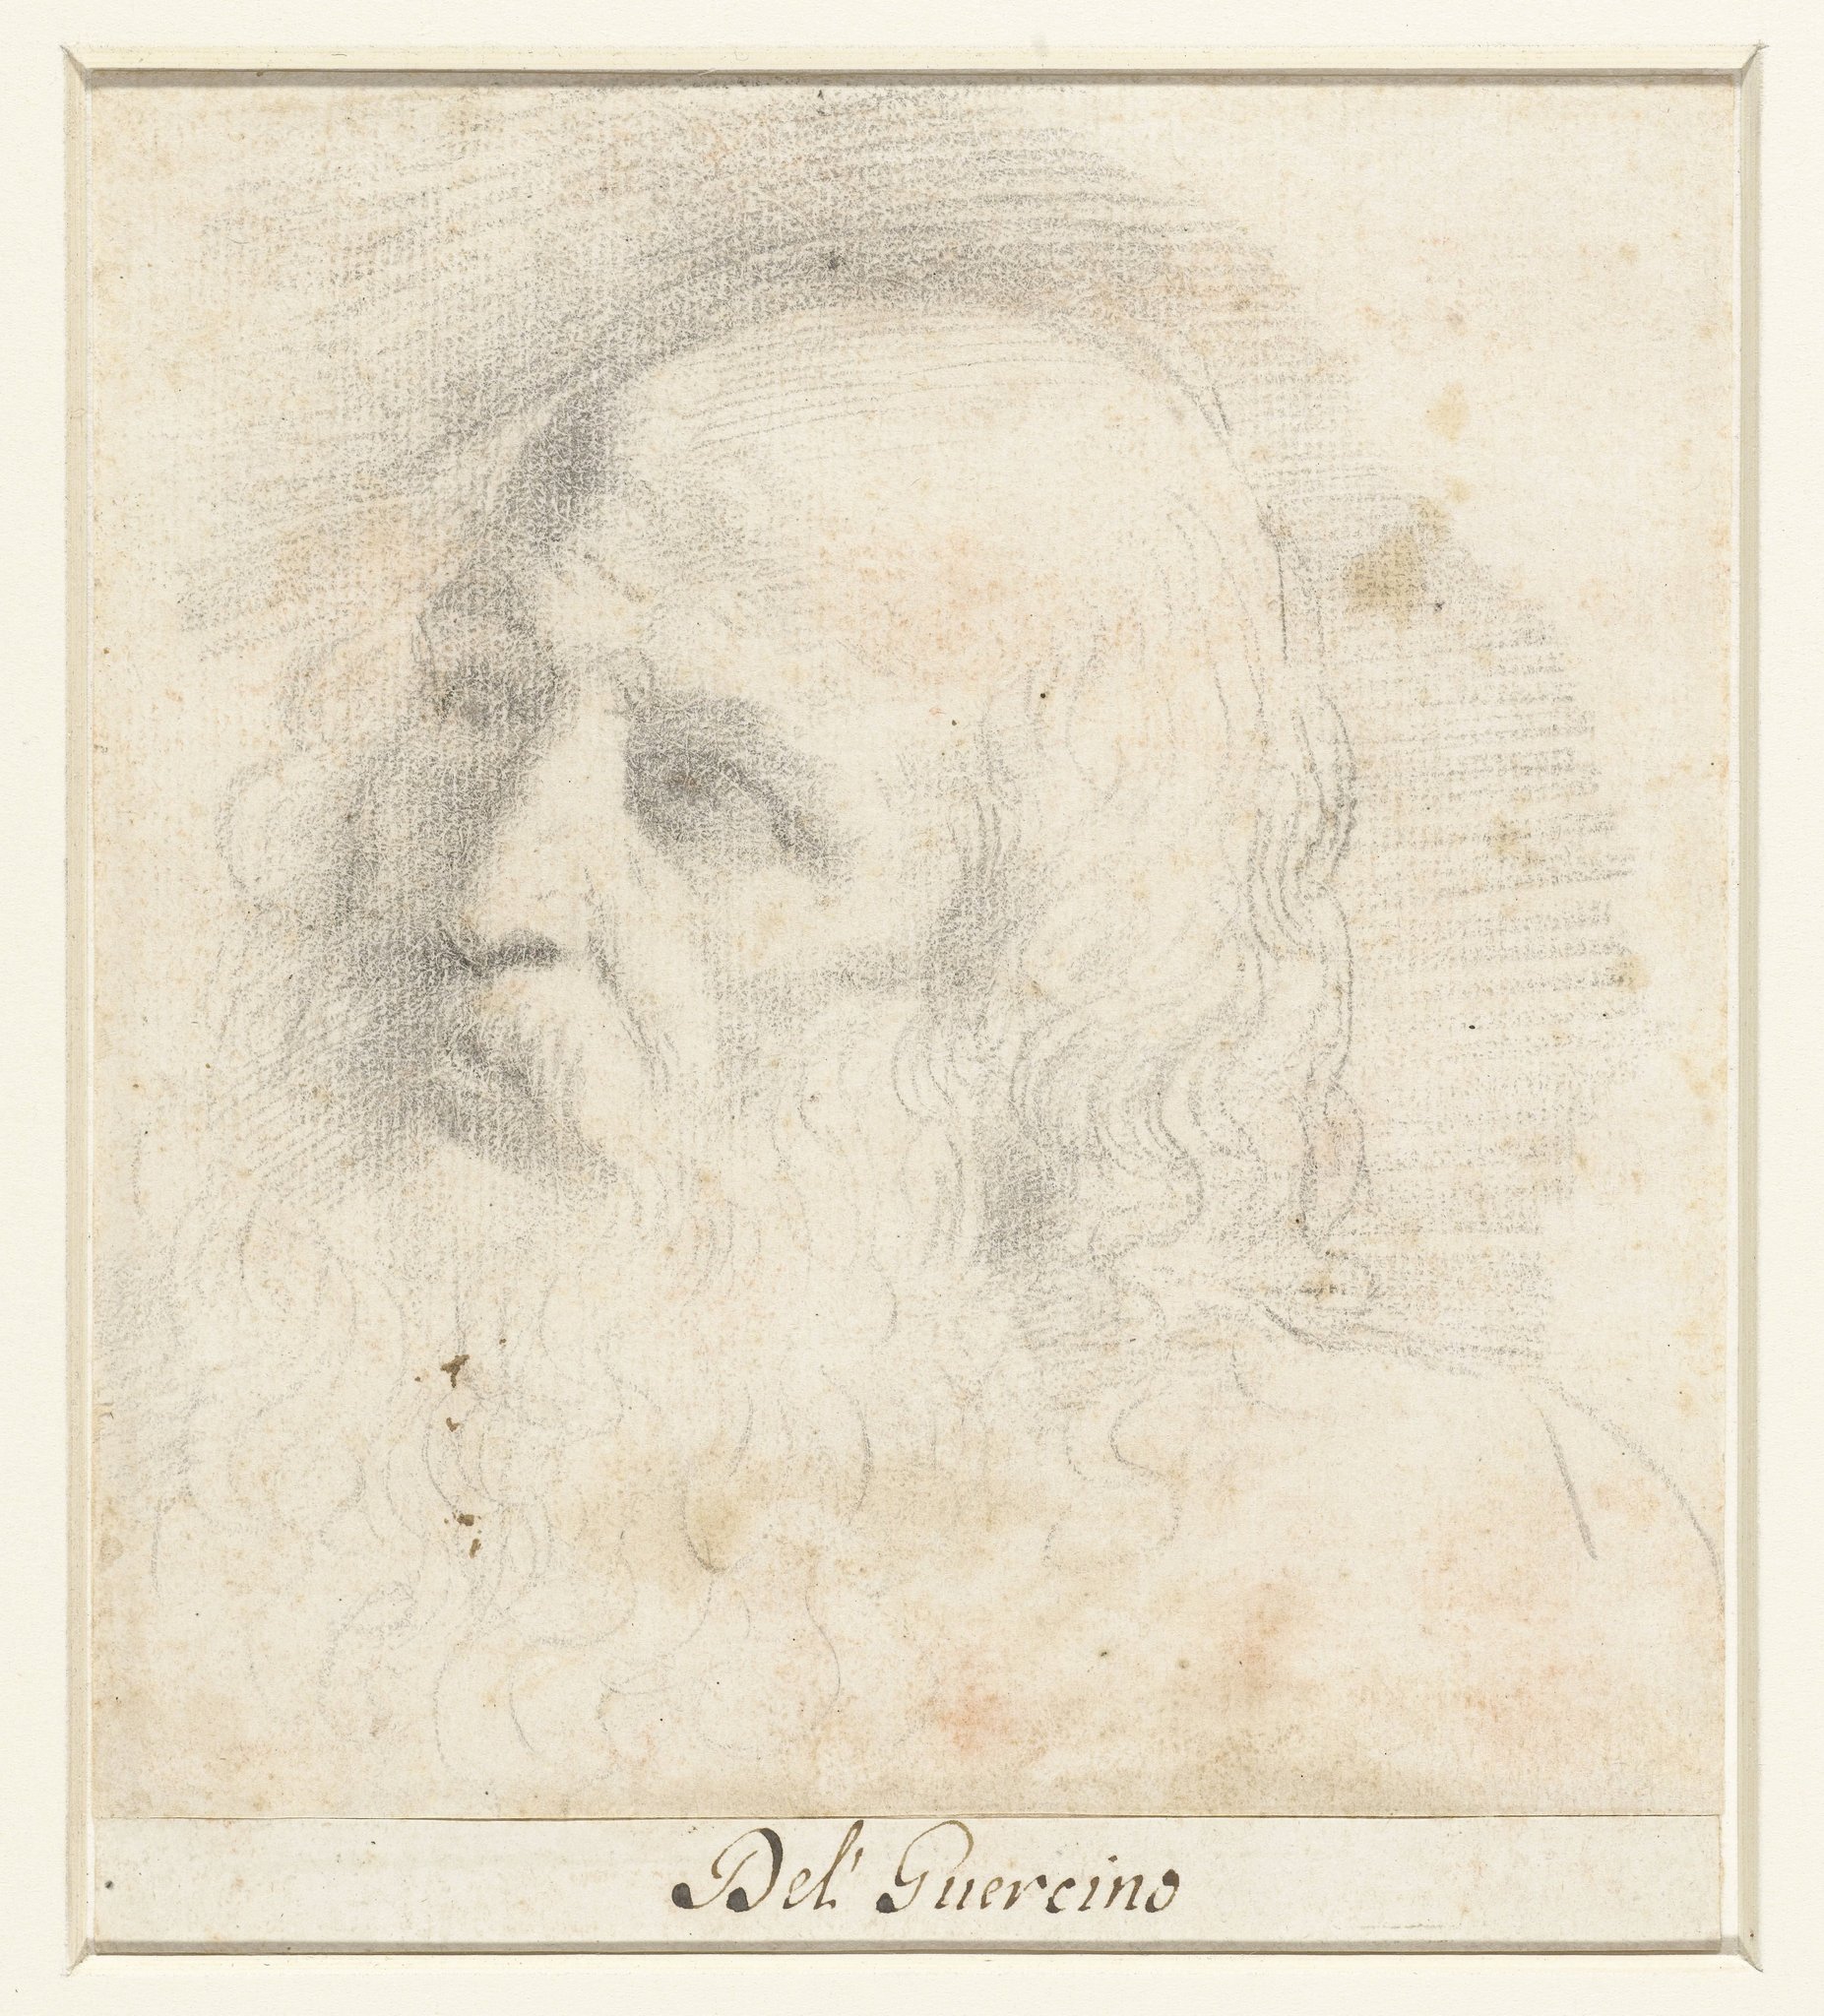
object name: drawing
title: Hoofd van een oude man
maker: g.jo.franc da cento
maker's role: draughtsman, painter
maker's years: 1591-1666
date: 1601-1666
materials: chalk, paper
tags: head (human), old man